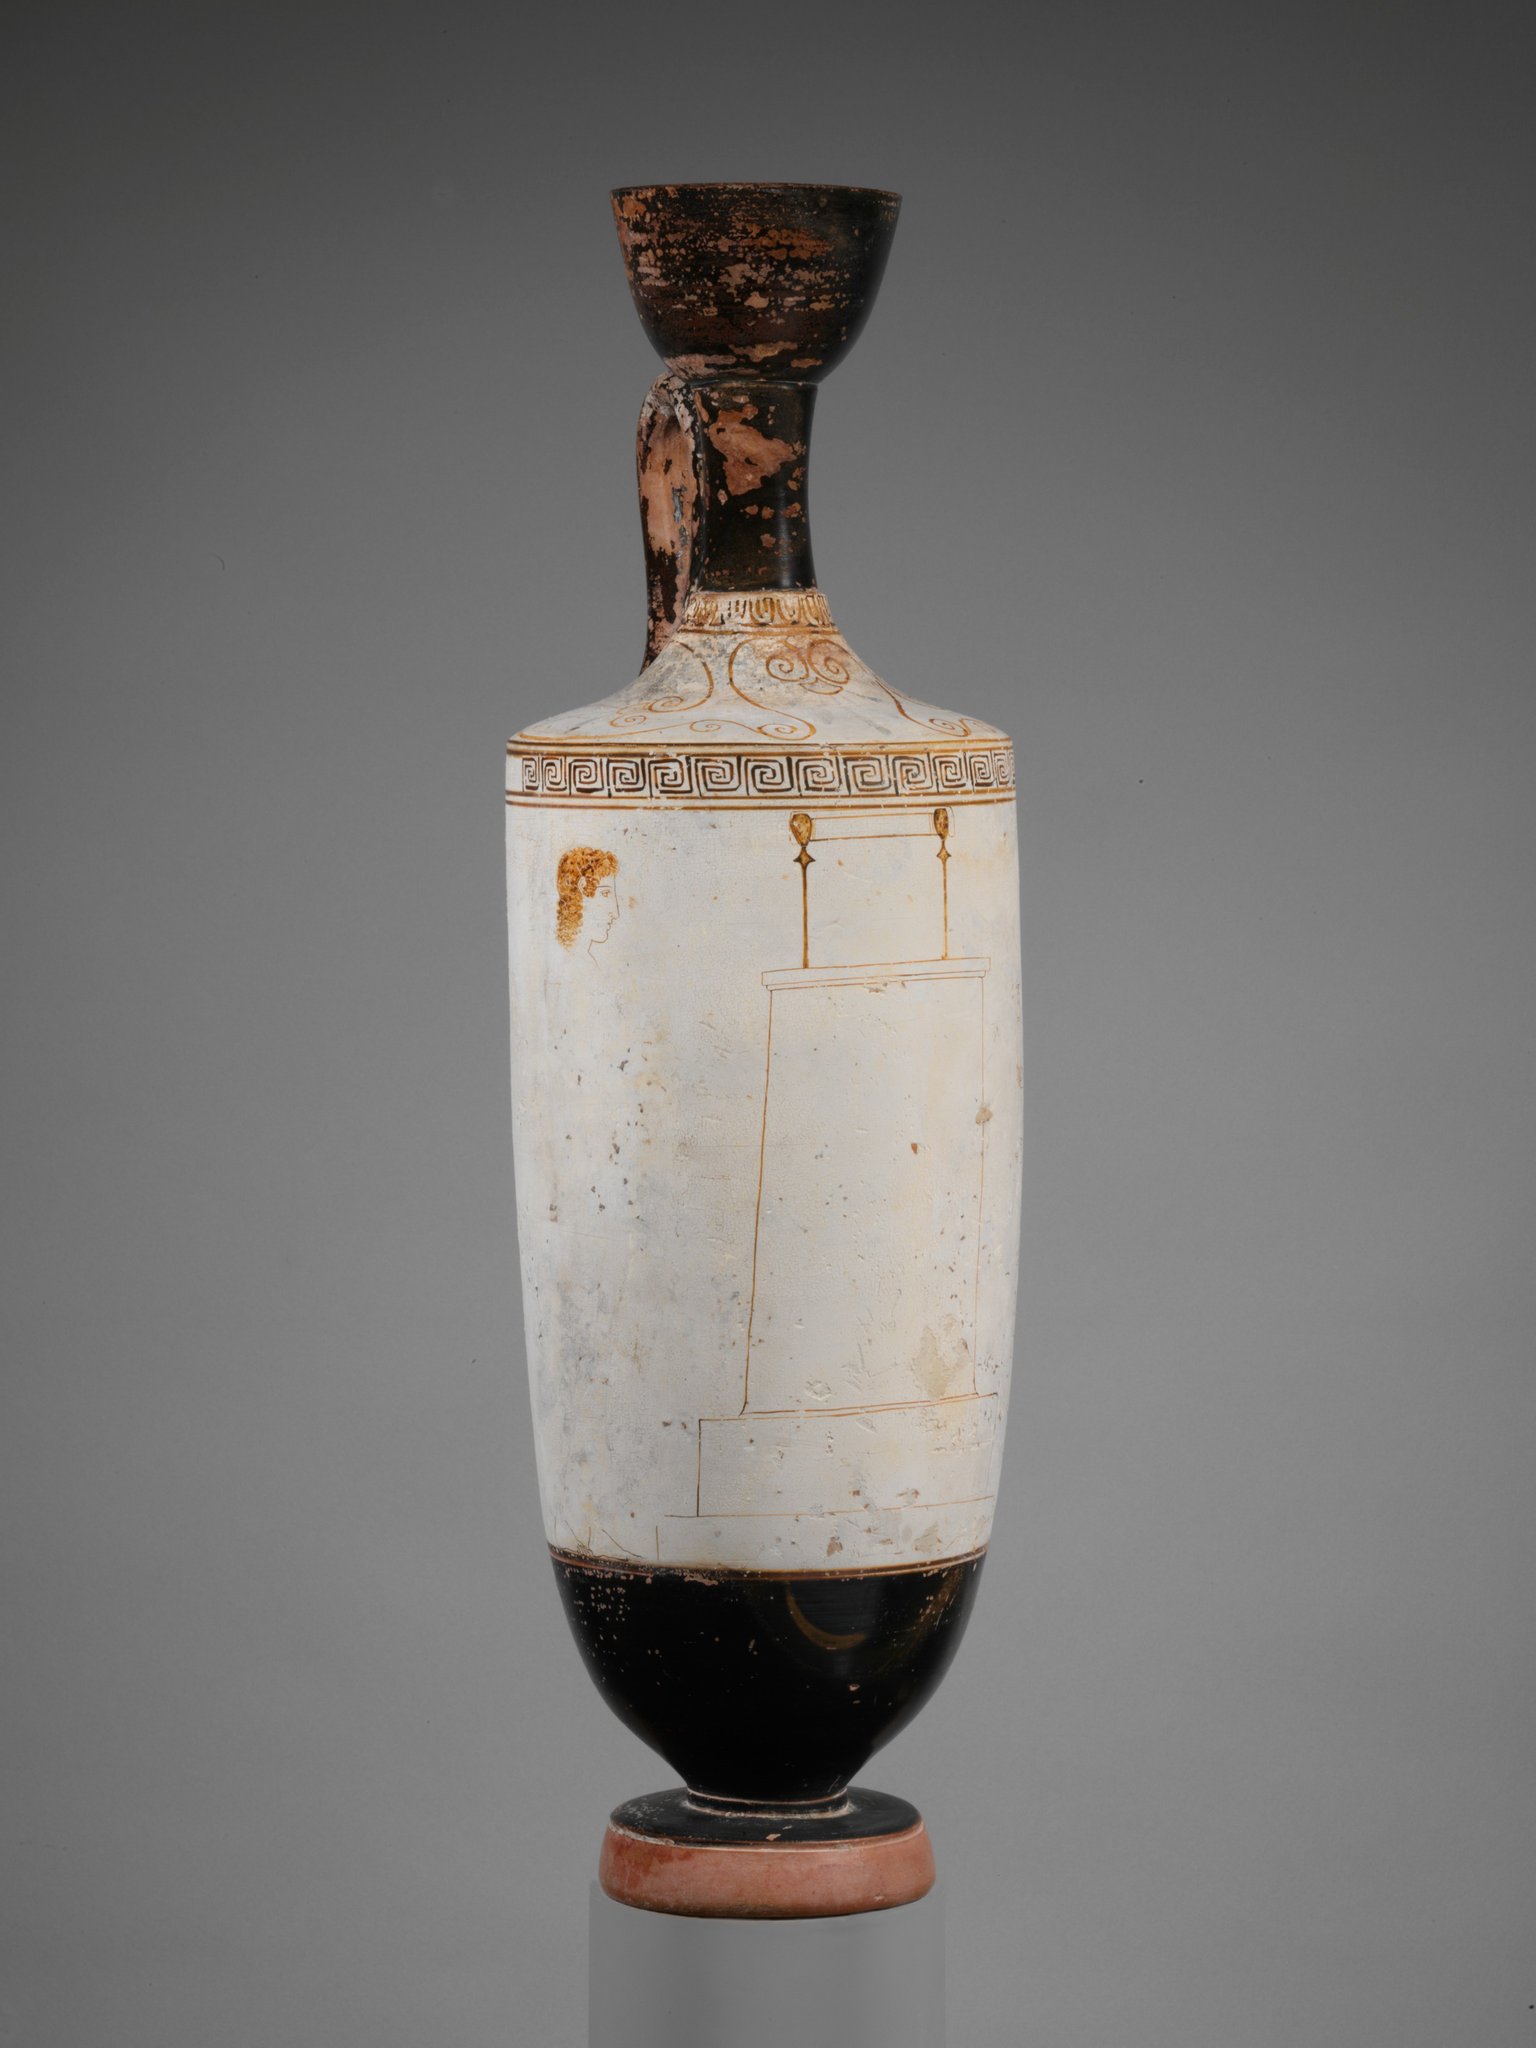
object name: lekythos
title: Terracotta lekythos (oil flask)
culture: greek, attic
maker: thanatos painter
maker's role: artist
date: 440-430 BCE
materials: terracotta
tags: tombs,women